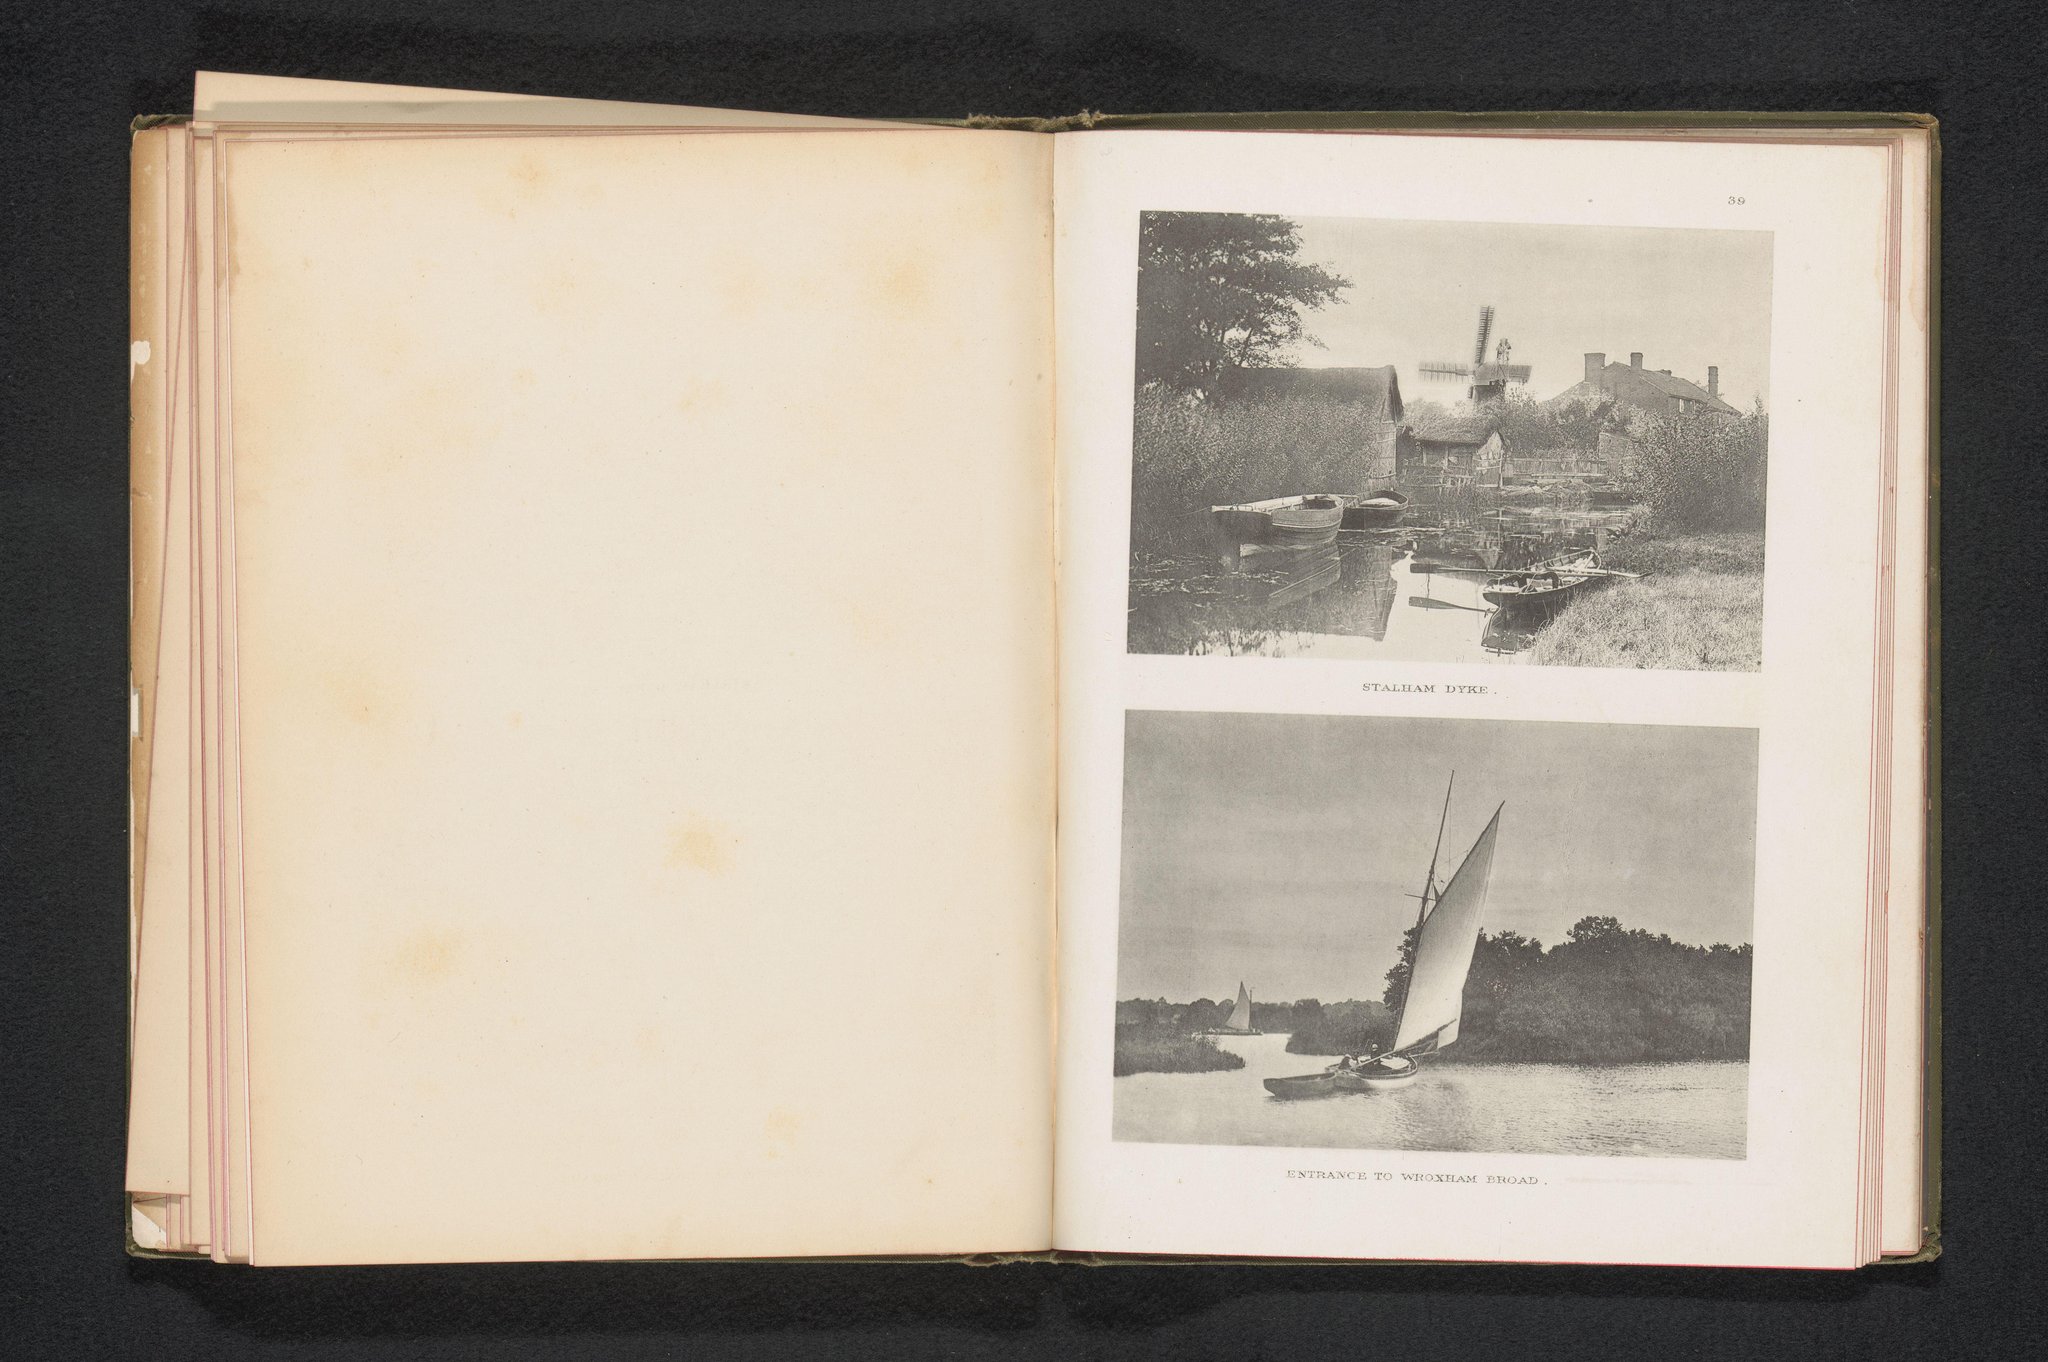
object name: page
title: Stalham dyke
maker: john payne jennings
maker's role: fotograaf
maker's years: 1843-1926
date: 1886-1891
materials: paper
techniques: photograph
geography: surrey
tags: city-view in general; 'veduta', landscapes with waters, waterscapes, seascapes (in the temperate zone), windmill in landscape